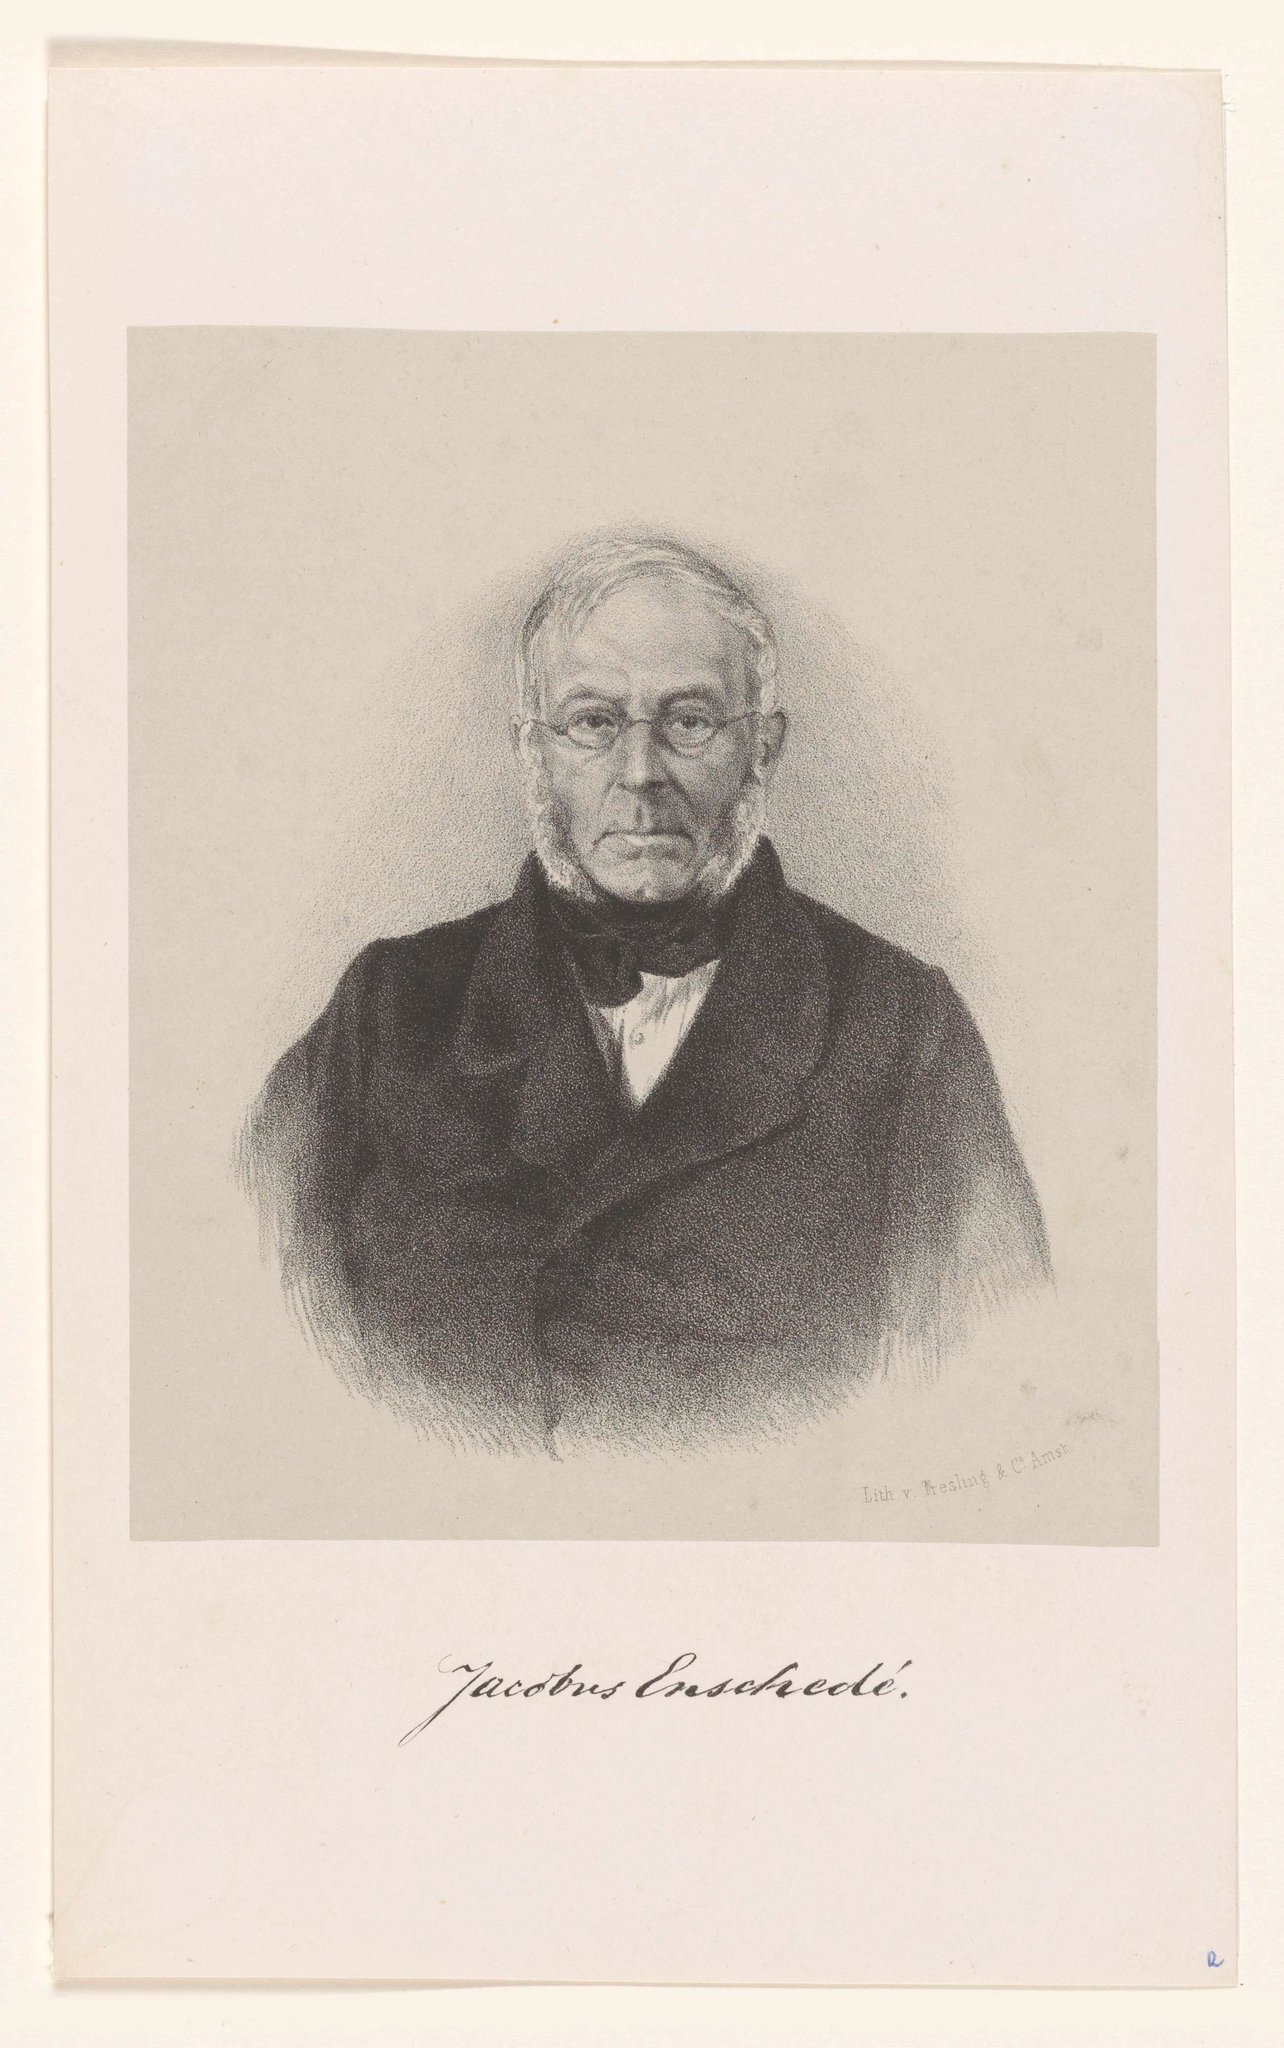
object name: print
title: Portret van Jacobus Enschedé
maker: Anonymous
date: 1867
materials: paper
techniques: lithograph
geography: amsterdam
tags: haarlem, printer, publisher, publishing, publisher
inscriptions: collector's mark: Lugt 2228, collector's mark: Lugt 4780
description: Jacobus Enschedé was vanaf 1820 hoofd van de drukkerij Johannes Enschedé en Zonen te Haarlem. Volgens Van Someren is de prent ook gebruikt in: Adresboek voor den Nederlandschen boekhandel, 1867.